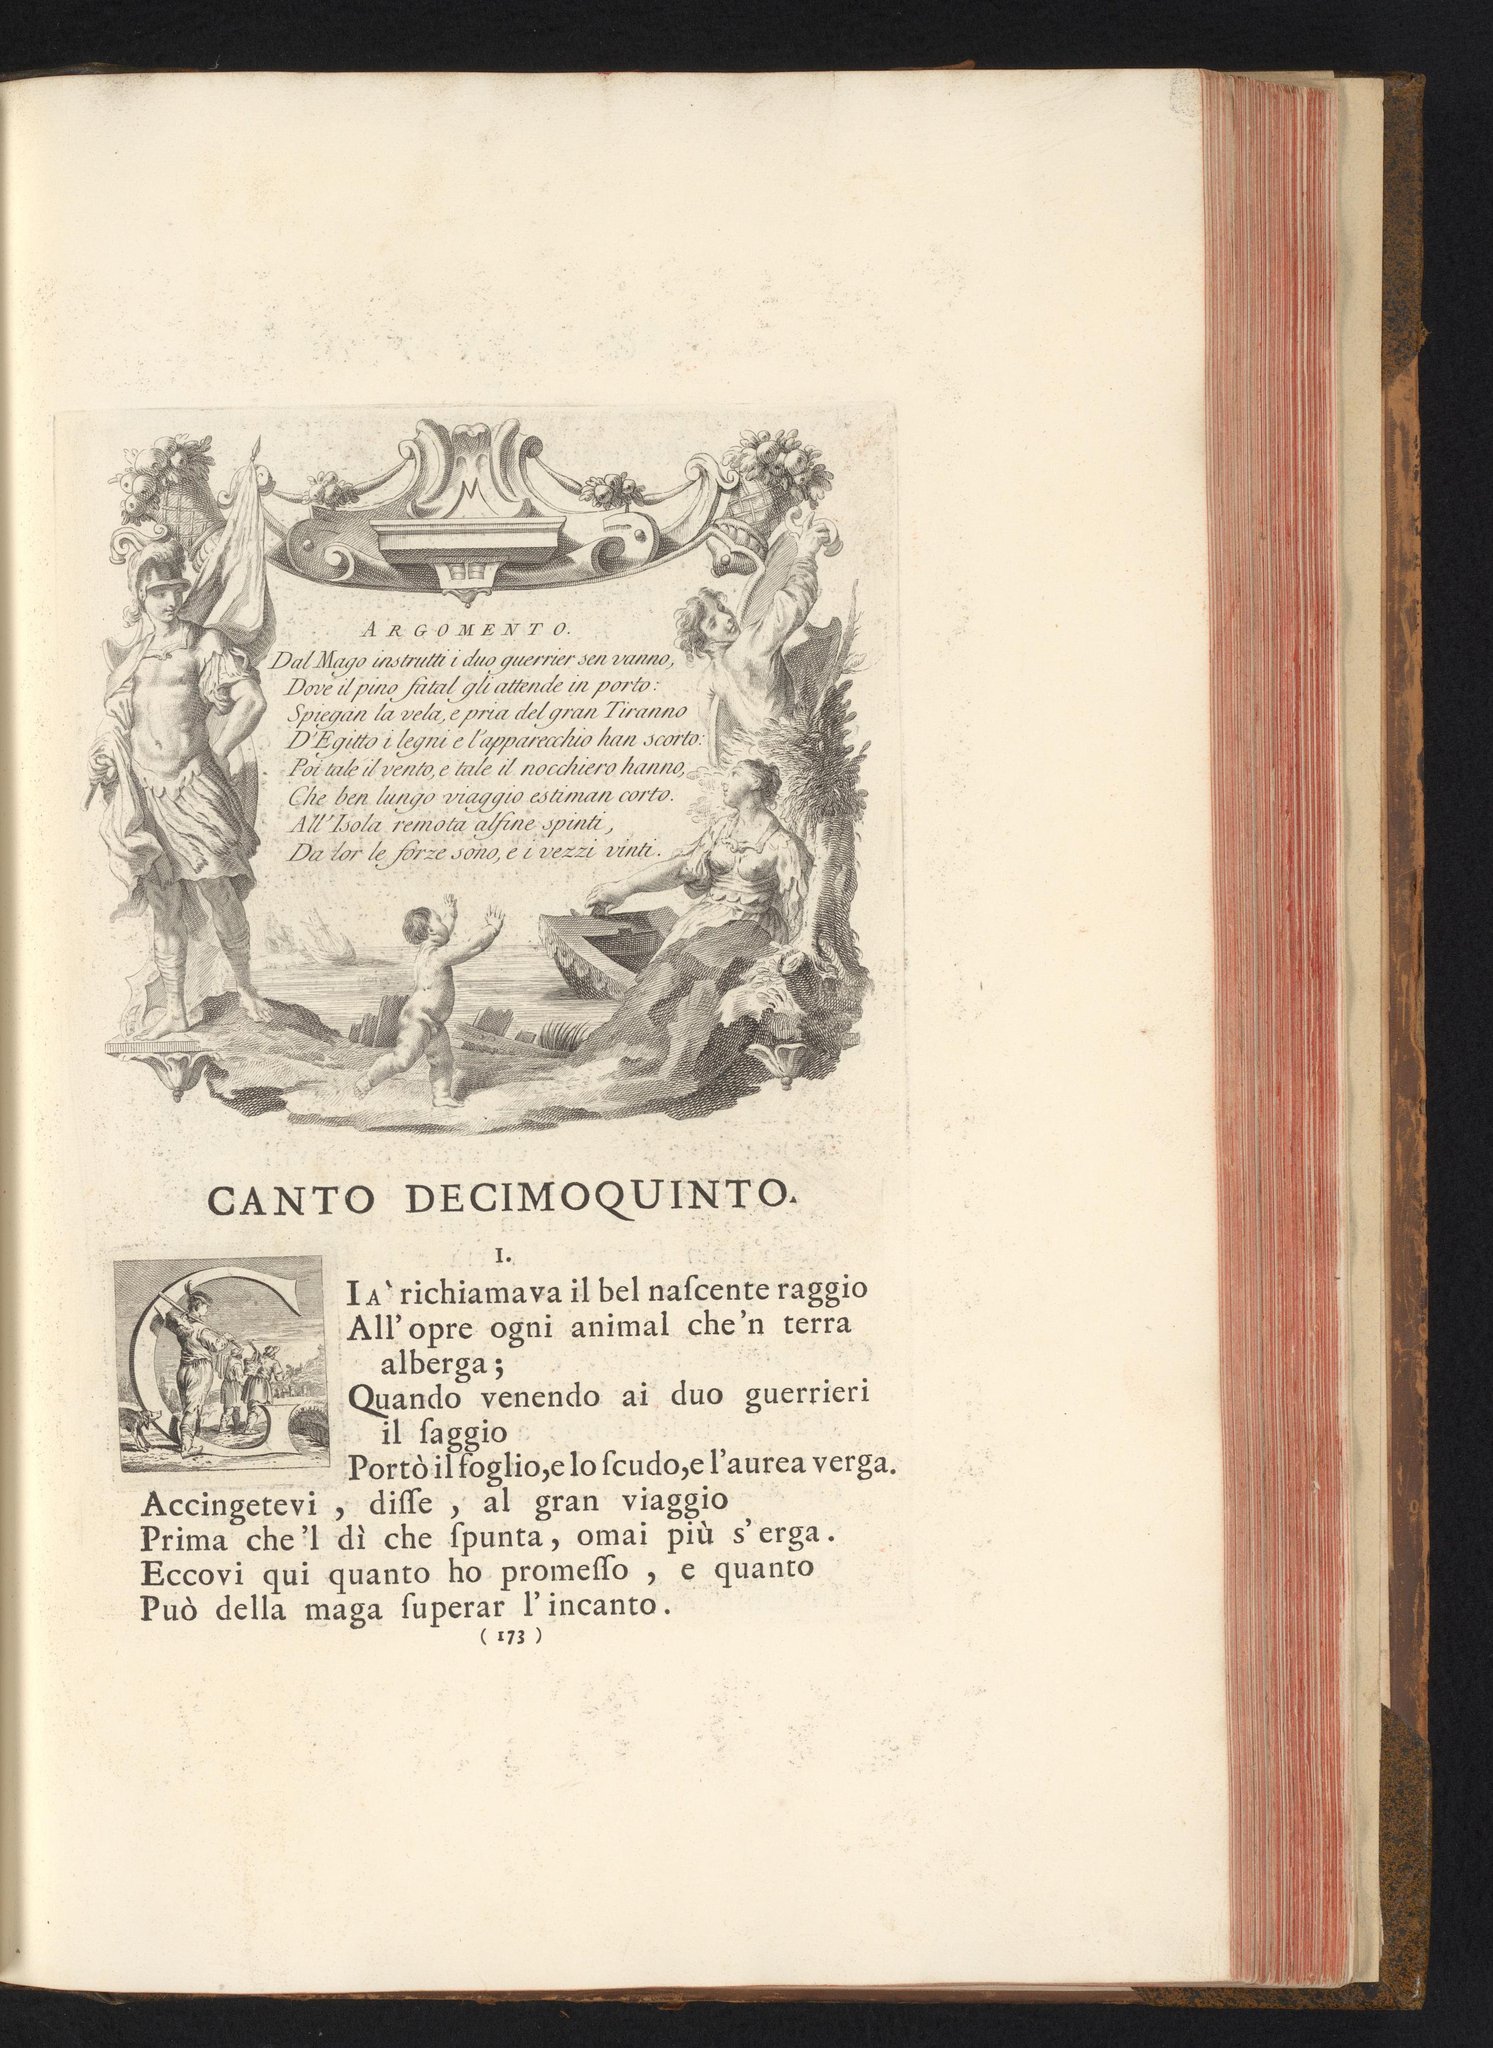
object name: book illustration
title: Kustlandschap met figuren en initiaal G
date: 1745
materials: paper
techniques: etching, letterpress printing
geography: venice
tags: initial, (scenes from) specific works of literature: tasso, gerusalemme liberata, coast (+ landscape with figures, staffage)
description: Prent uit: Tasso, Torquato. La Gerusalemme liberata di Torquato Tasso con le figure de Giambatista Piazzetta. Venetië: Giambatista Albrizzi, 1745.